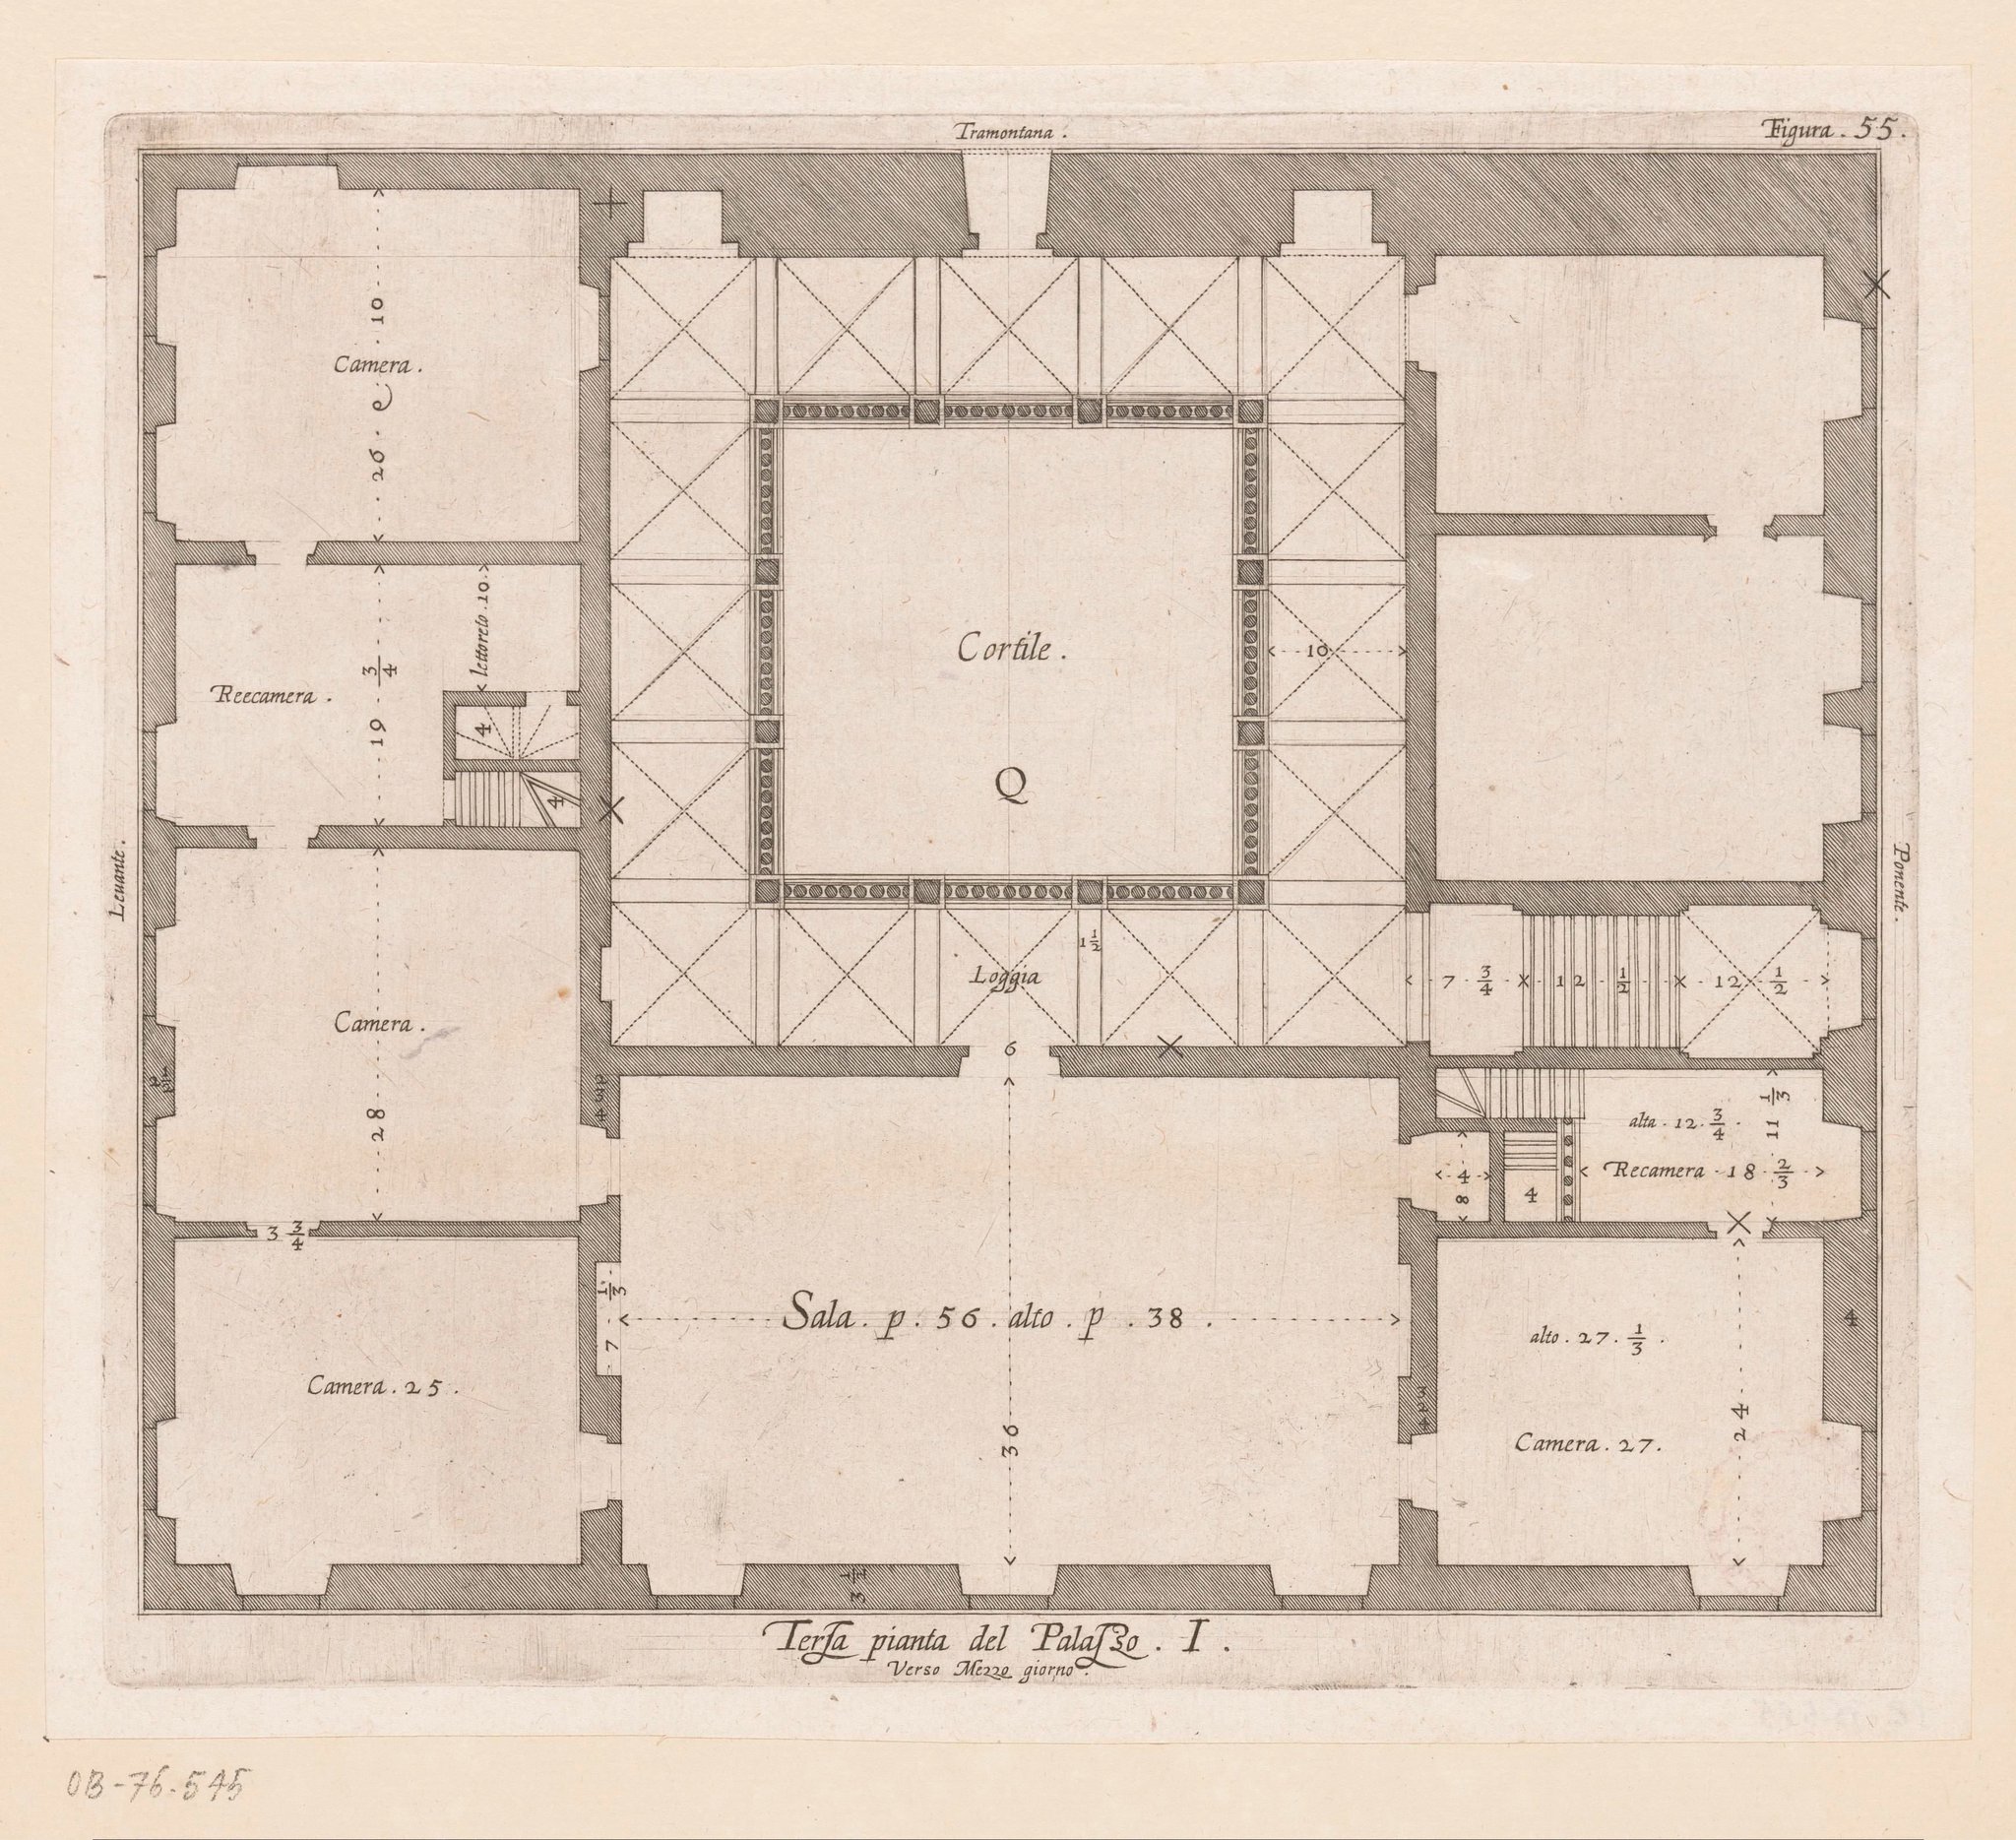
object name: print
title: Opstand van de façade van het Palazzo Rostan Raggio te Genua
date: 1622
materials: paper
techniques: engraving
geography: antwerp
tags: hôtel, i.e. small palace in city, façade (of house or building), exterior ~ architectural design or model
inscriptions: collector's mark: Lugt 240